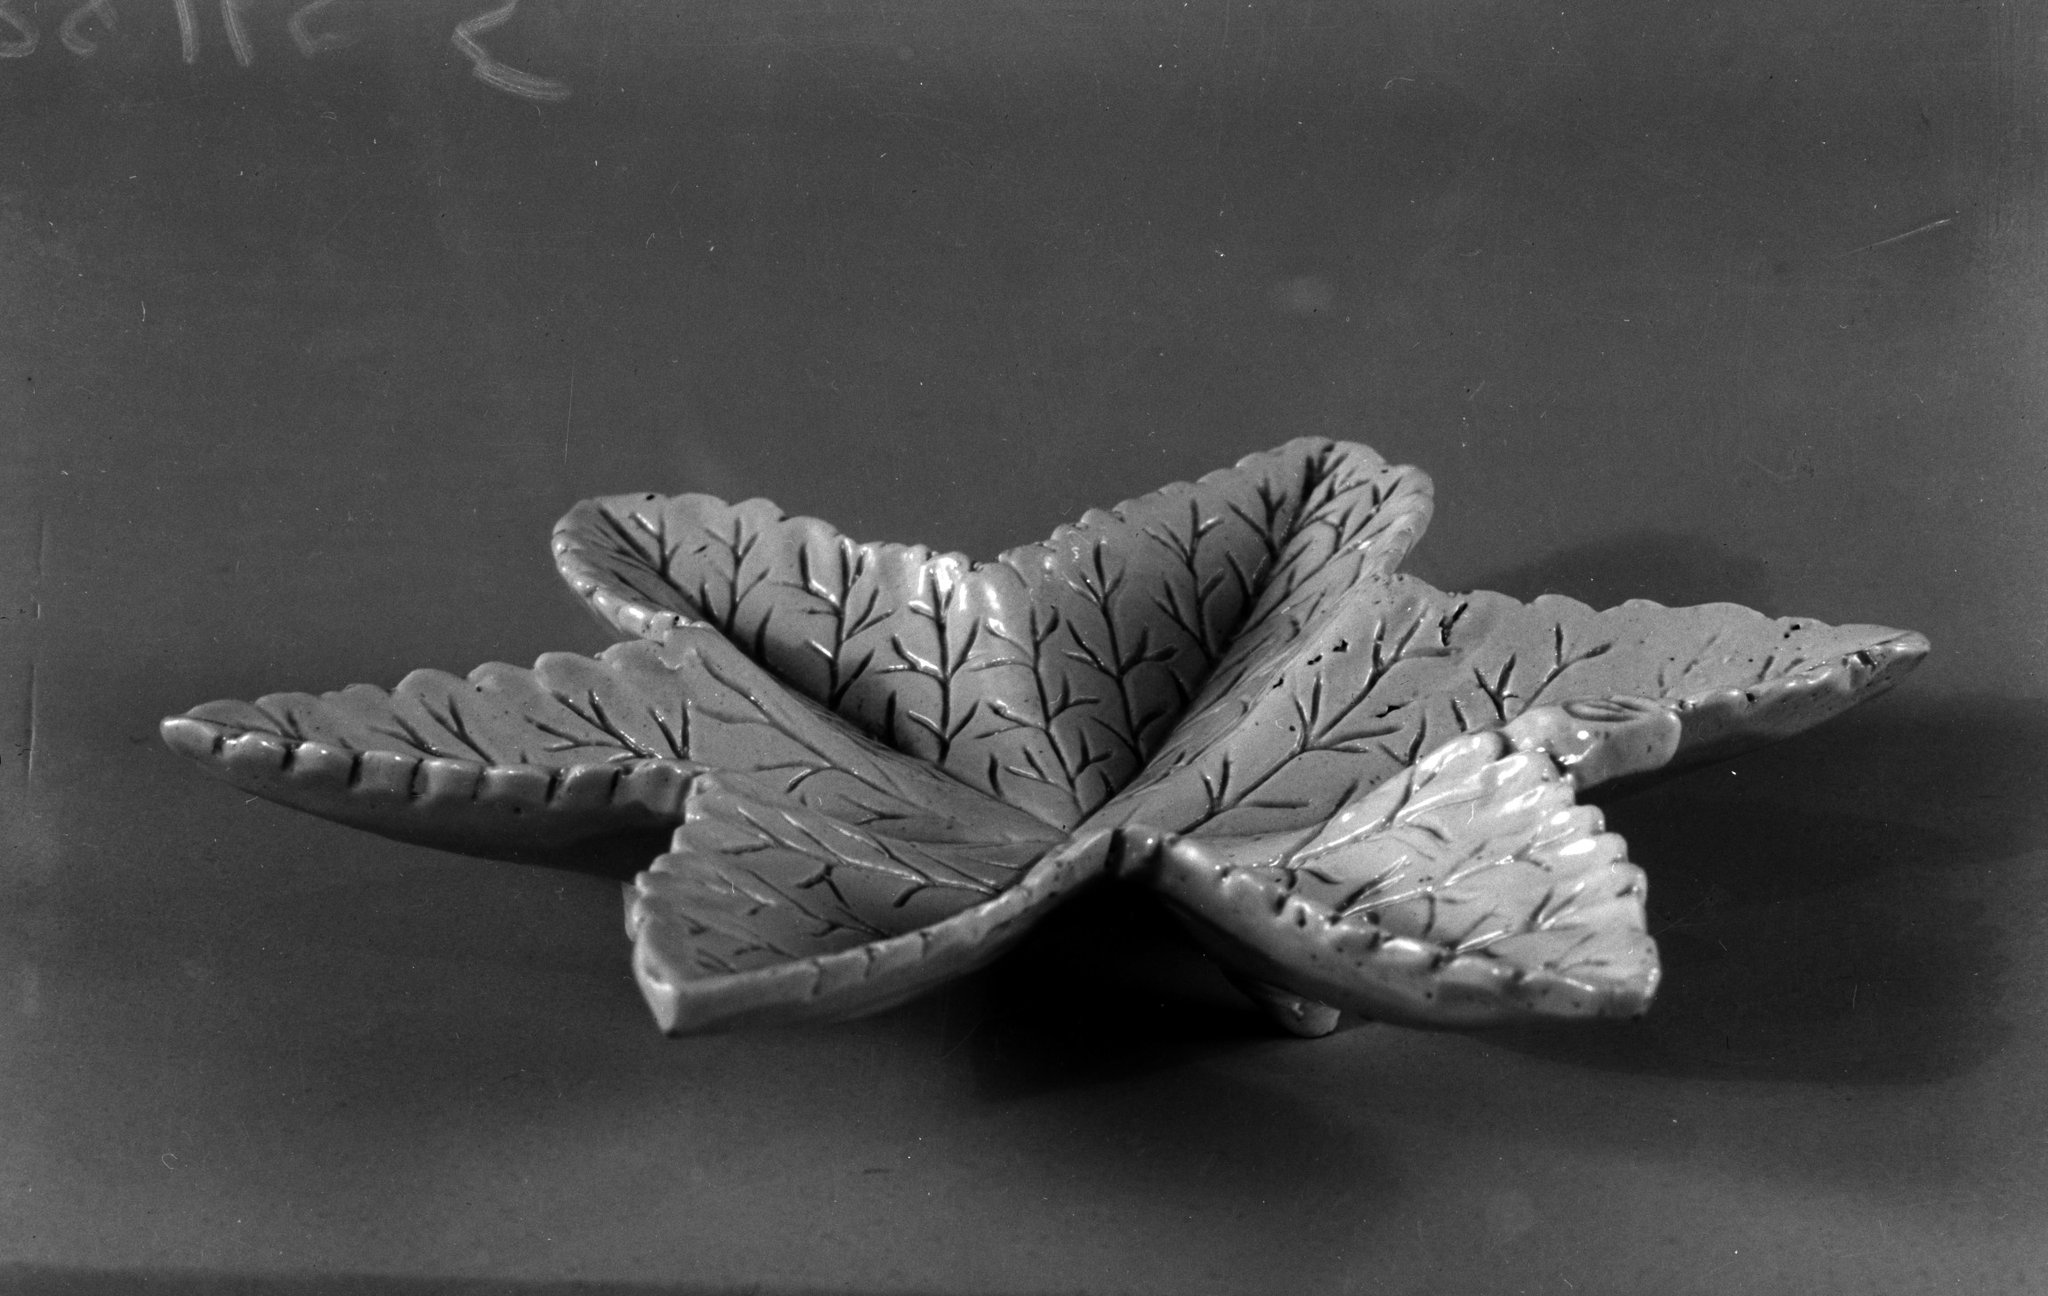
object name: pickle dish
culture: british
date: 1750-1770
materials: stoneware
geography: england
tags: leaves